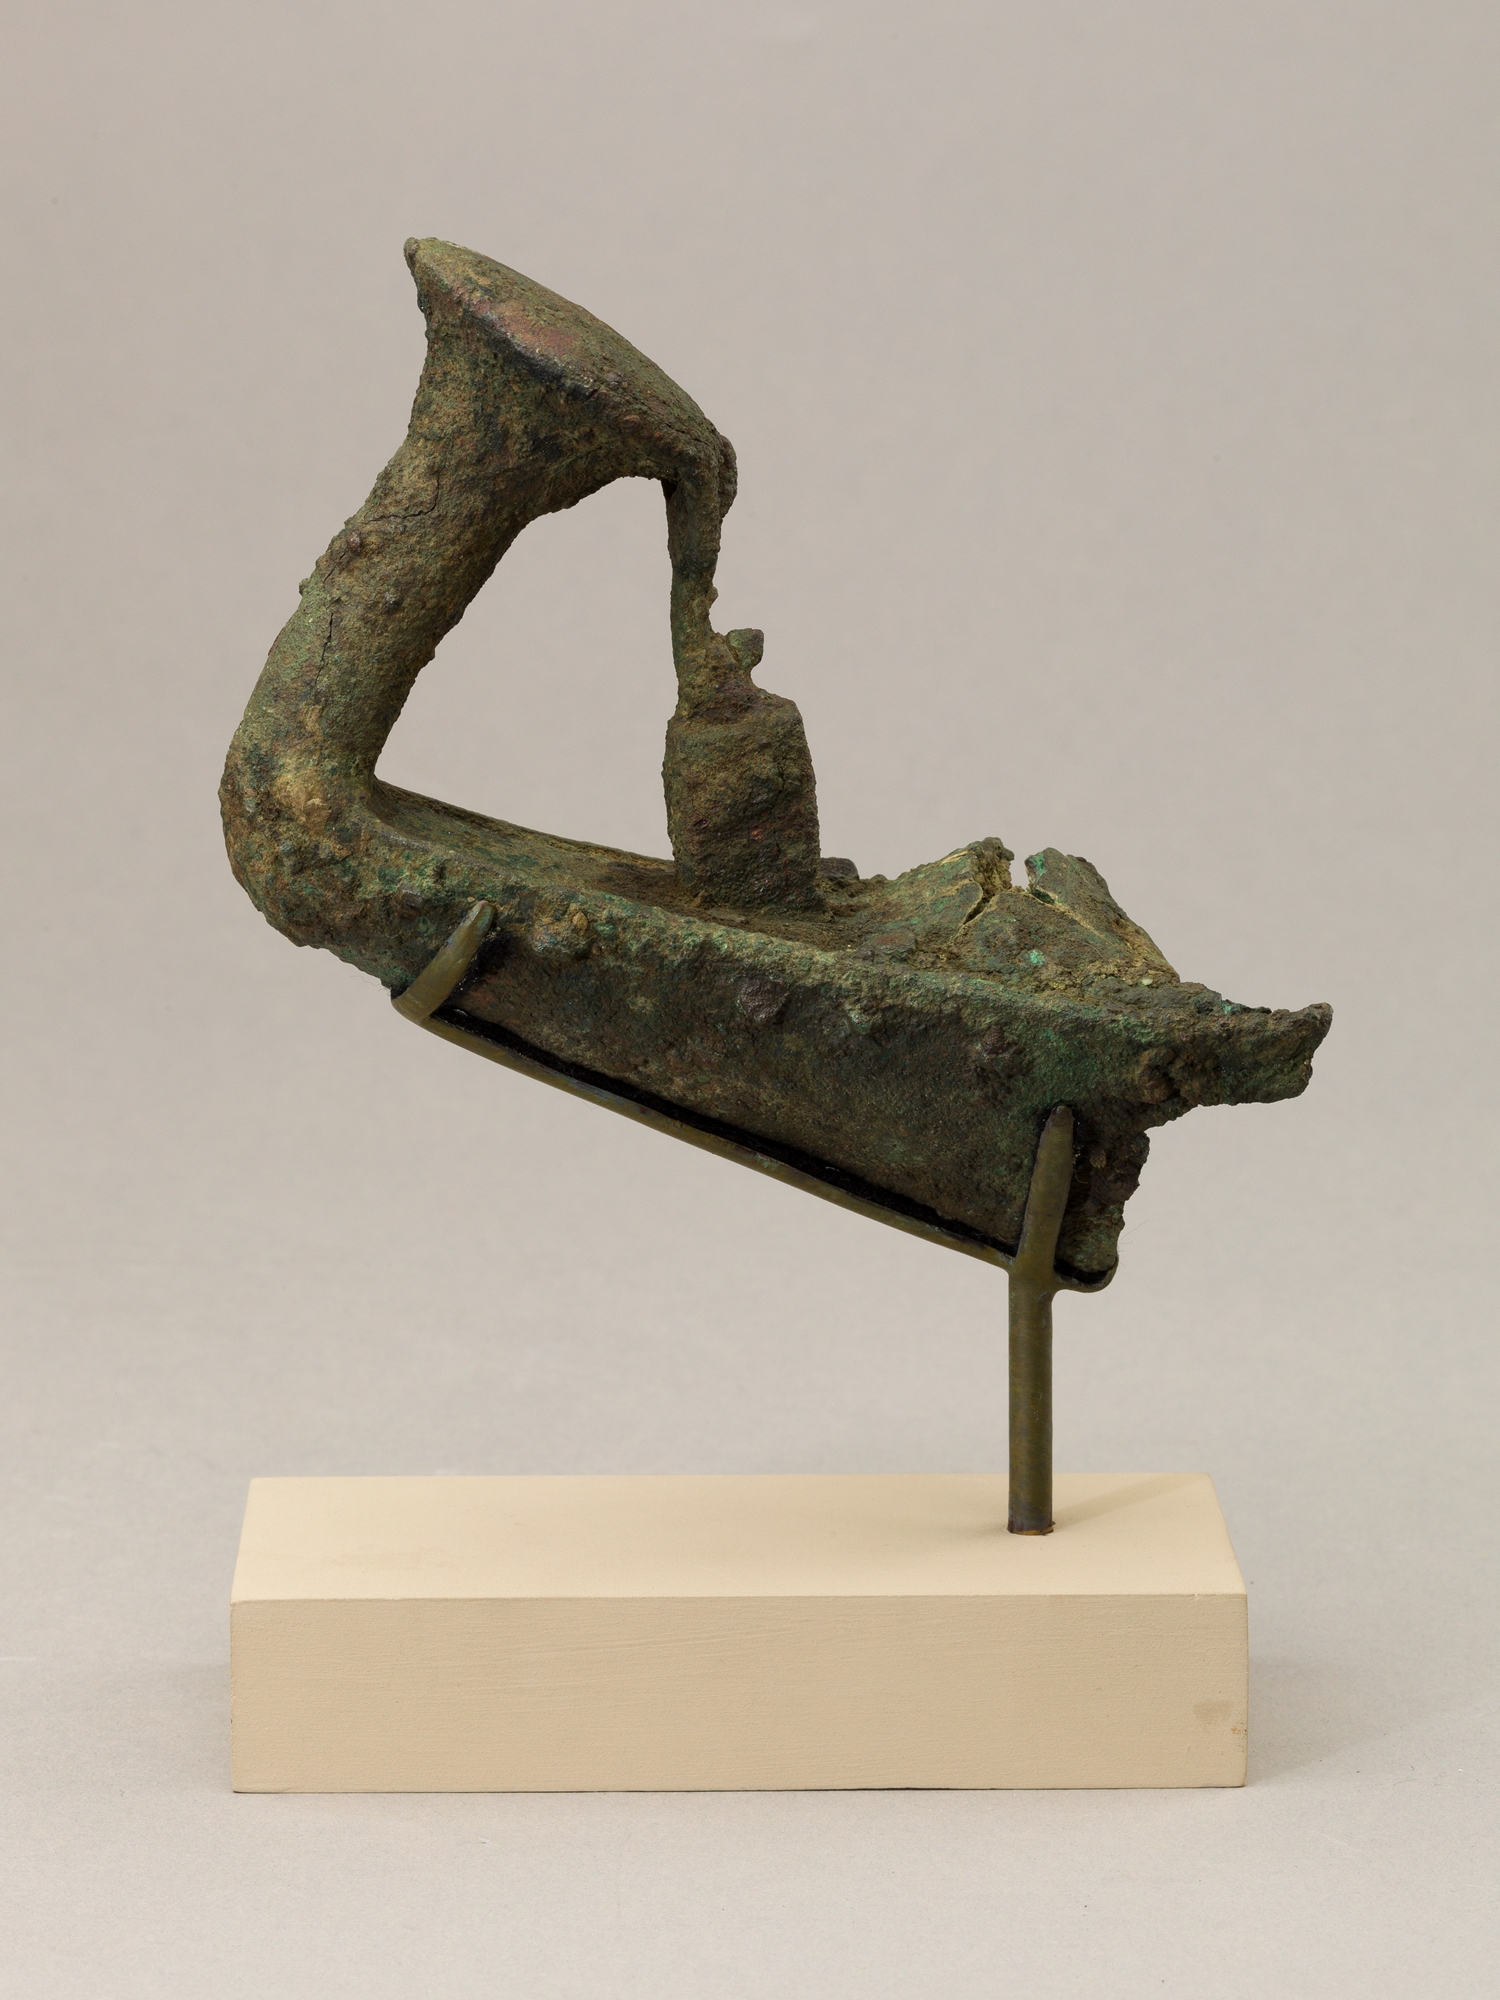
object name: standard, barque fragment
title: Stern of a barque from a standard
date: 664-630 BCE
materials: metal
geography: egypt